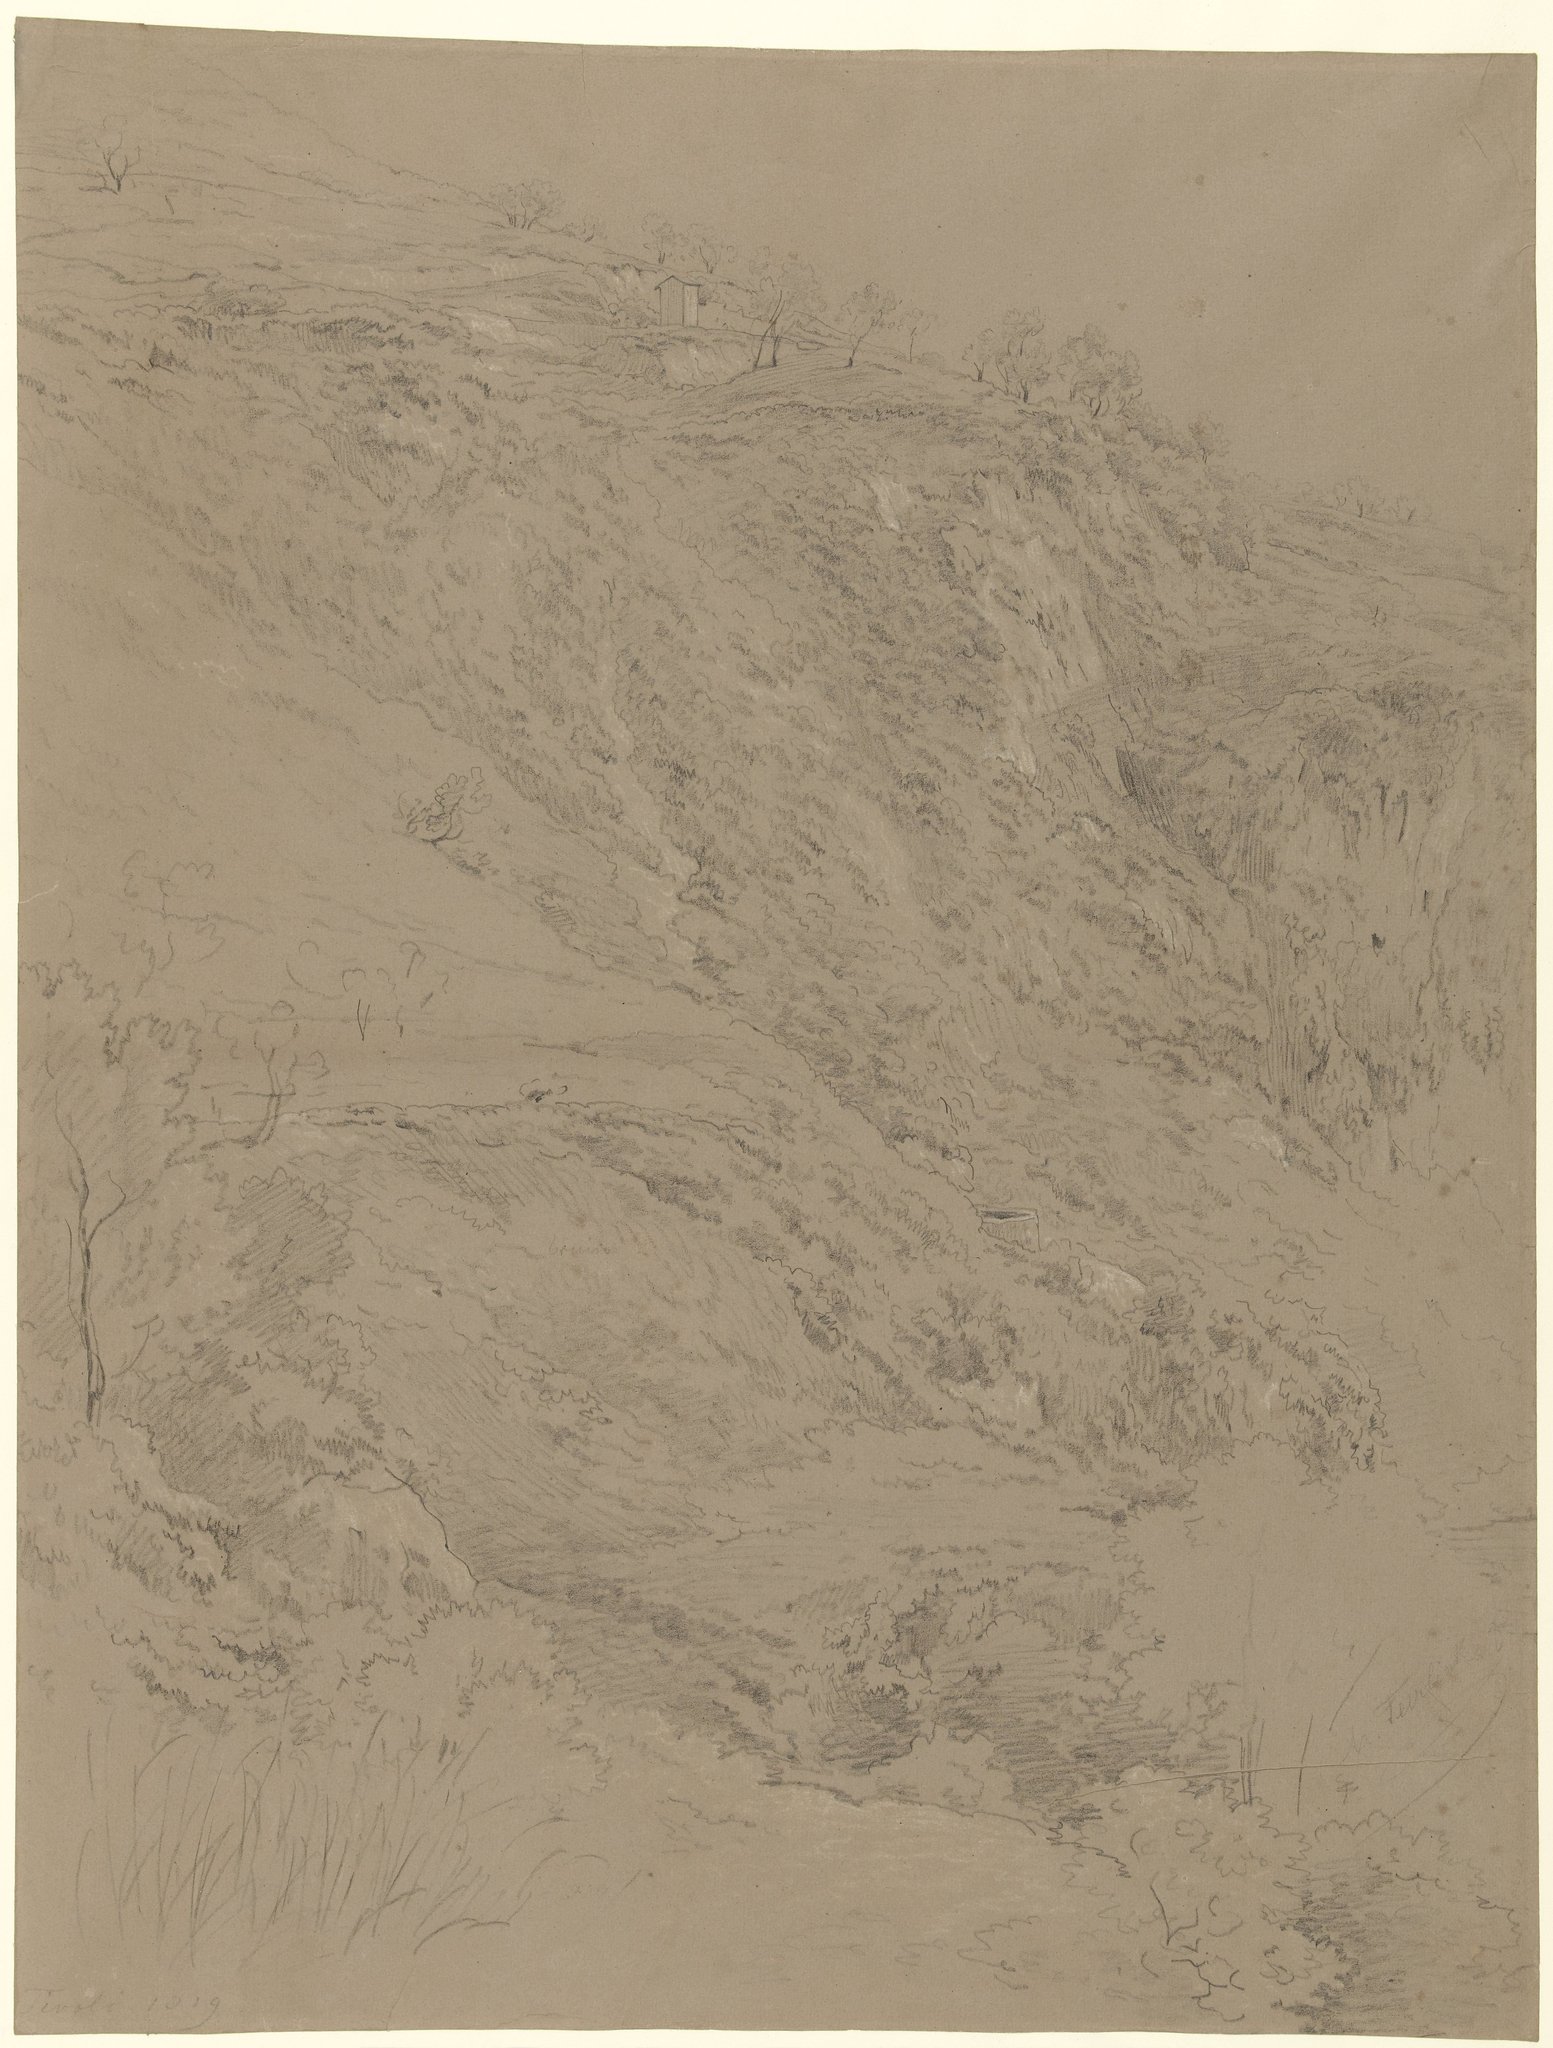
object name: drawing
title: Heuvellandschap bij Tivoli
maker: abraham teerlink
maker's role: draughtsman, painter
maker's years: 1776-1857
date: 1809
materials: chalk, paper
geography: tivoli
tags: landscapes, italy, tivoli